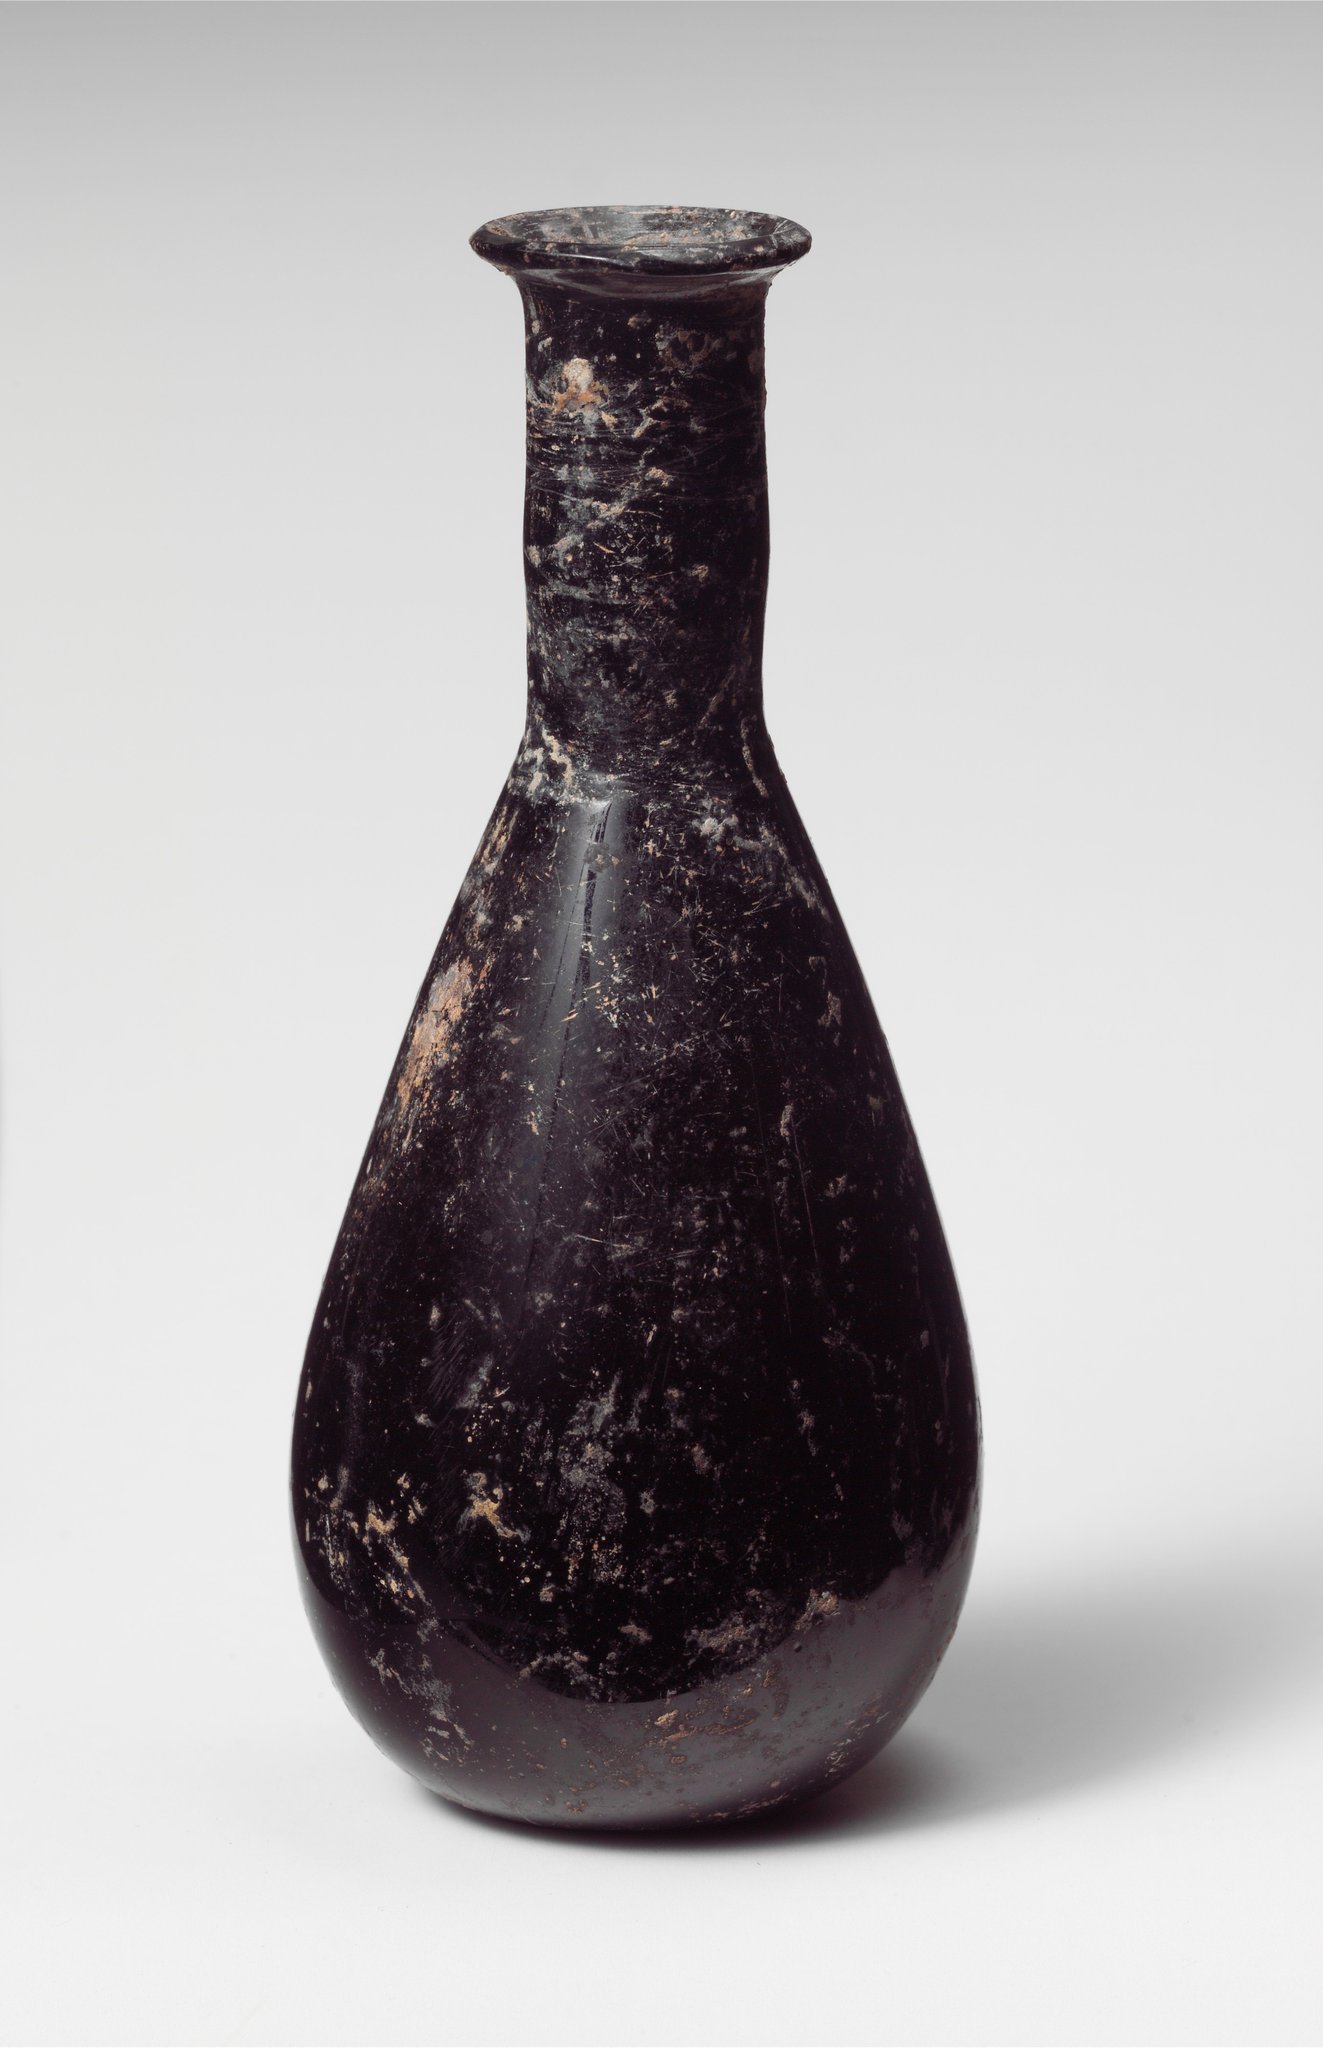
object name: perfume bottle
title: Glass perfume bottle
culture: roman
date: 1-100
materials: glass